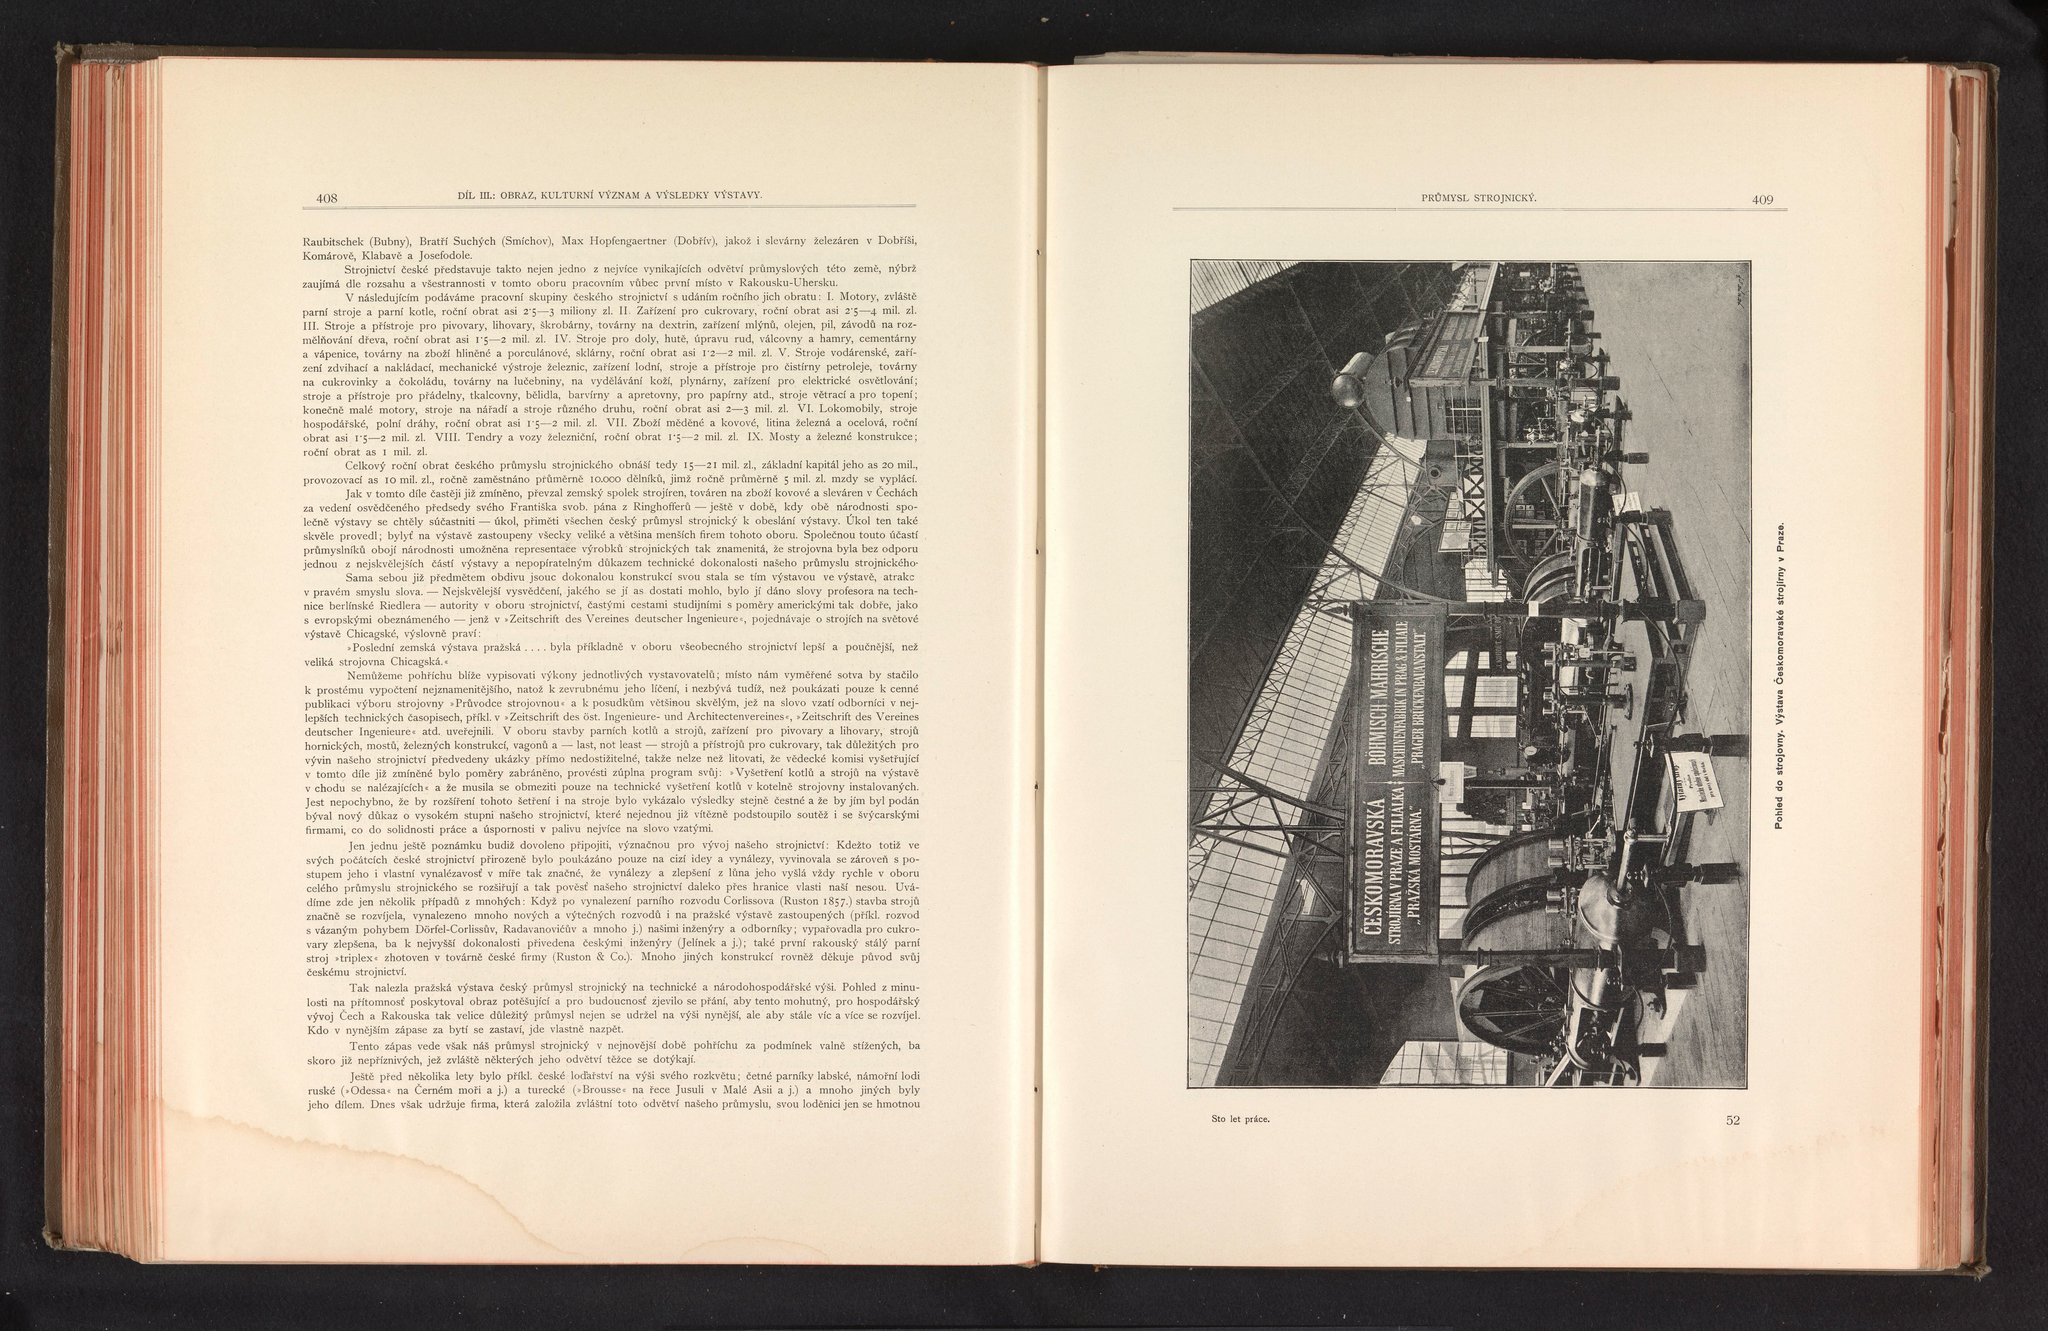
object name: photomechanical print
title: Interieur van een machinekamer met een tentoonstelling van Tsjechisch-Moravische machines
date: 1890-1895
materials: paper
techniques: autotype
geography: prague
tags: machines; parts of machines; tools and appliances, interior ~ representation of a building